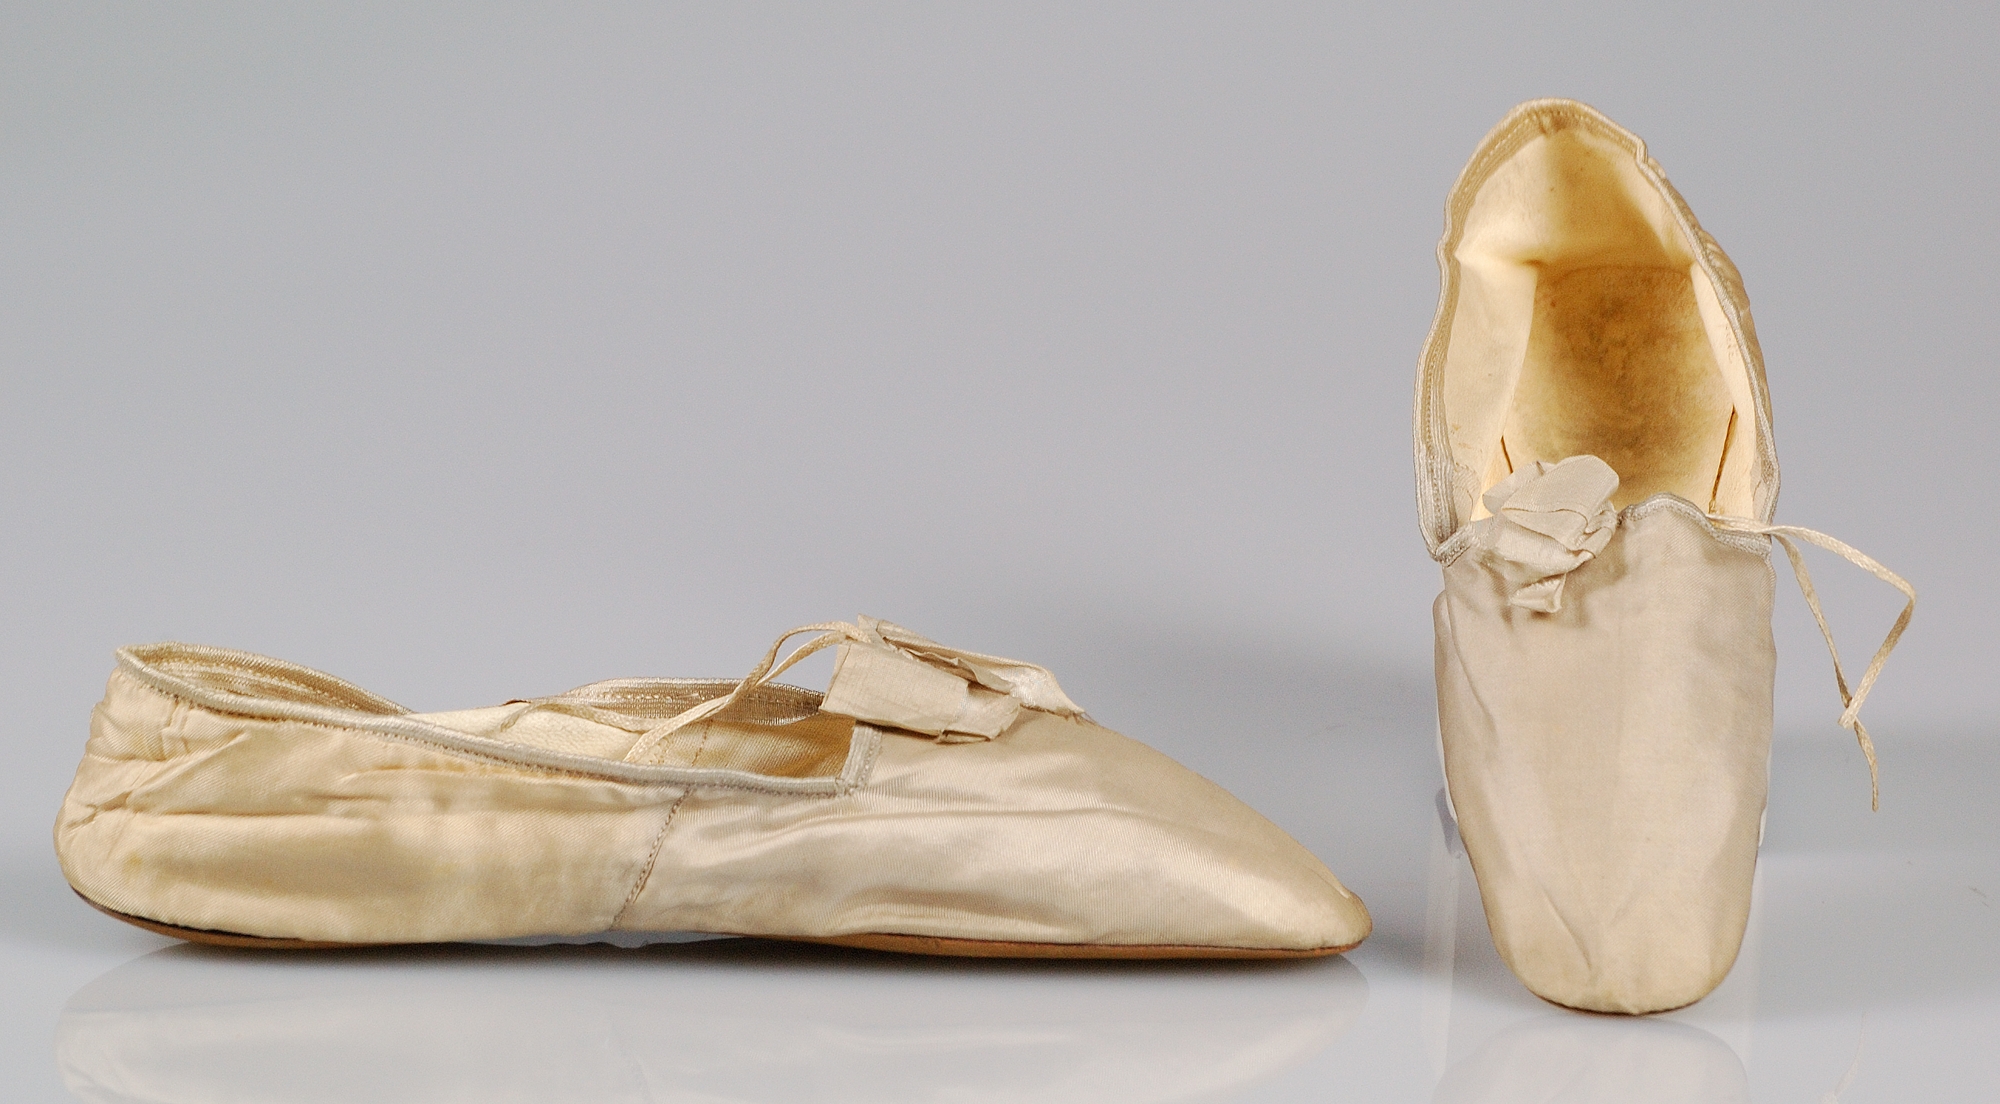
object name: evening slipper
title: Evening slippers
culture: french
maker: p. rouillier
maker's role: maker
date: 1845-1865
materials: silk